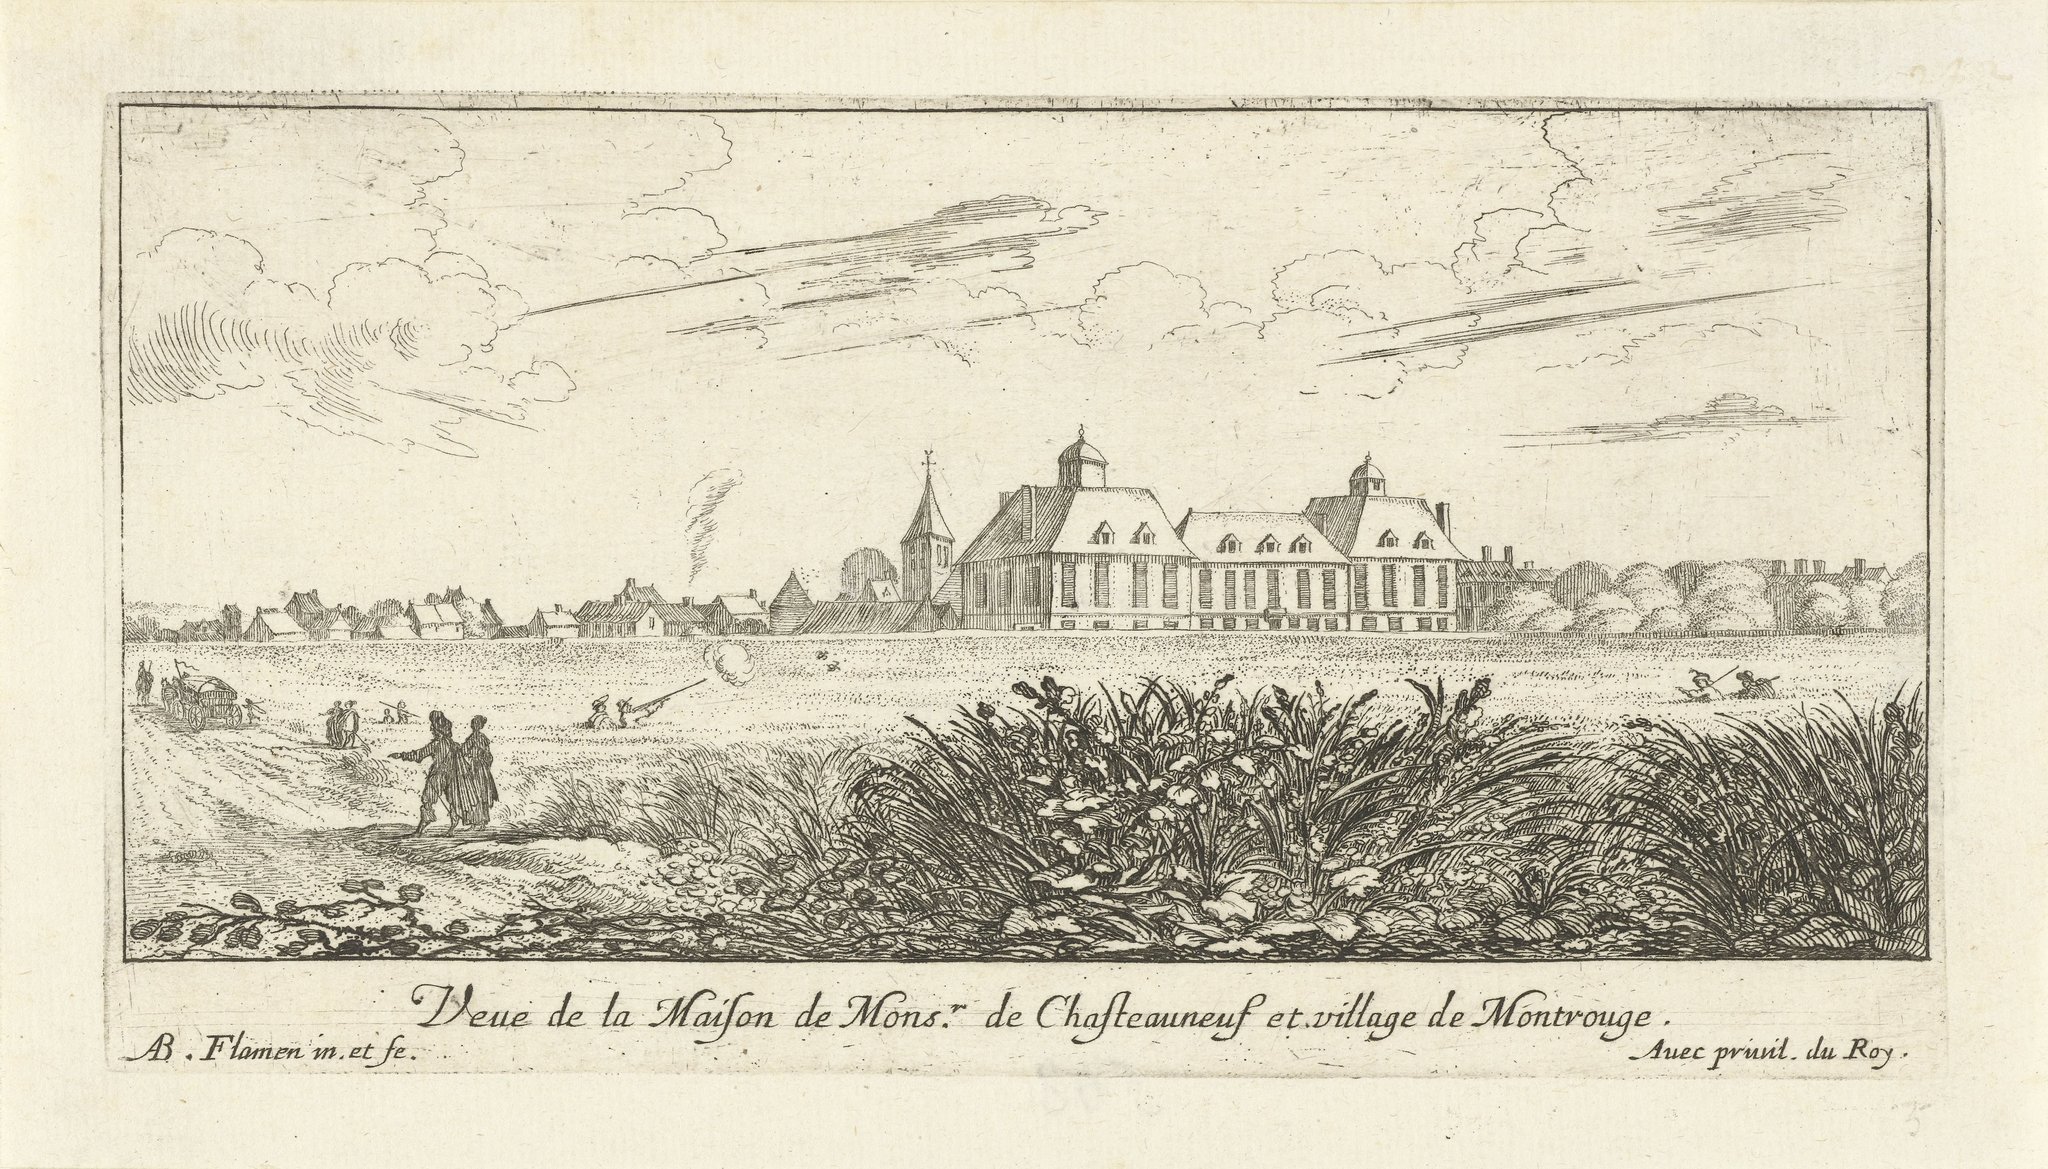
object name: print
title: Landhuis bij Montrouge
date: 1648-1692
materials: paper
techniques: etching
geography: paris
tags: rural housing, e.g. country-house, villa, cottage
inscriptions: collector's mark: Lugt 2161, collector's mark: Lugt 2228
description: Gezicht op het grote landhuis van de markies de Chasteauneuf en de huizen van het dorp Montrouge. Op de voorgrond gras en planten, waarachter een wandelend stel en een korenveld met jagers.